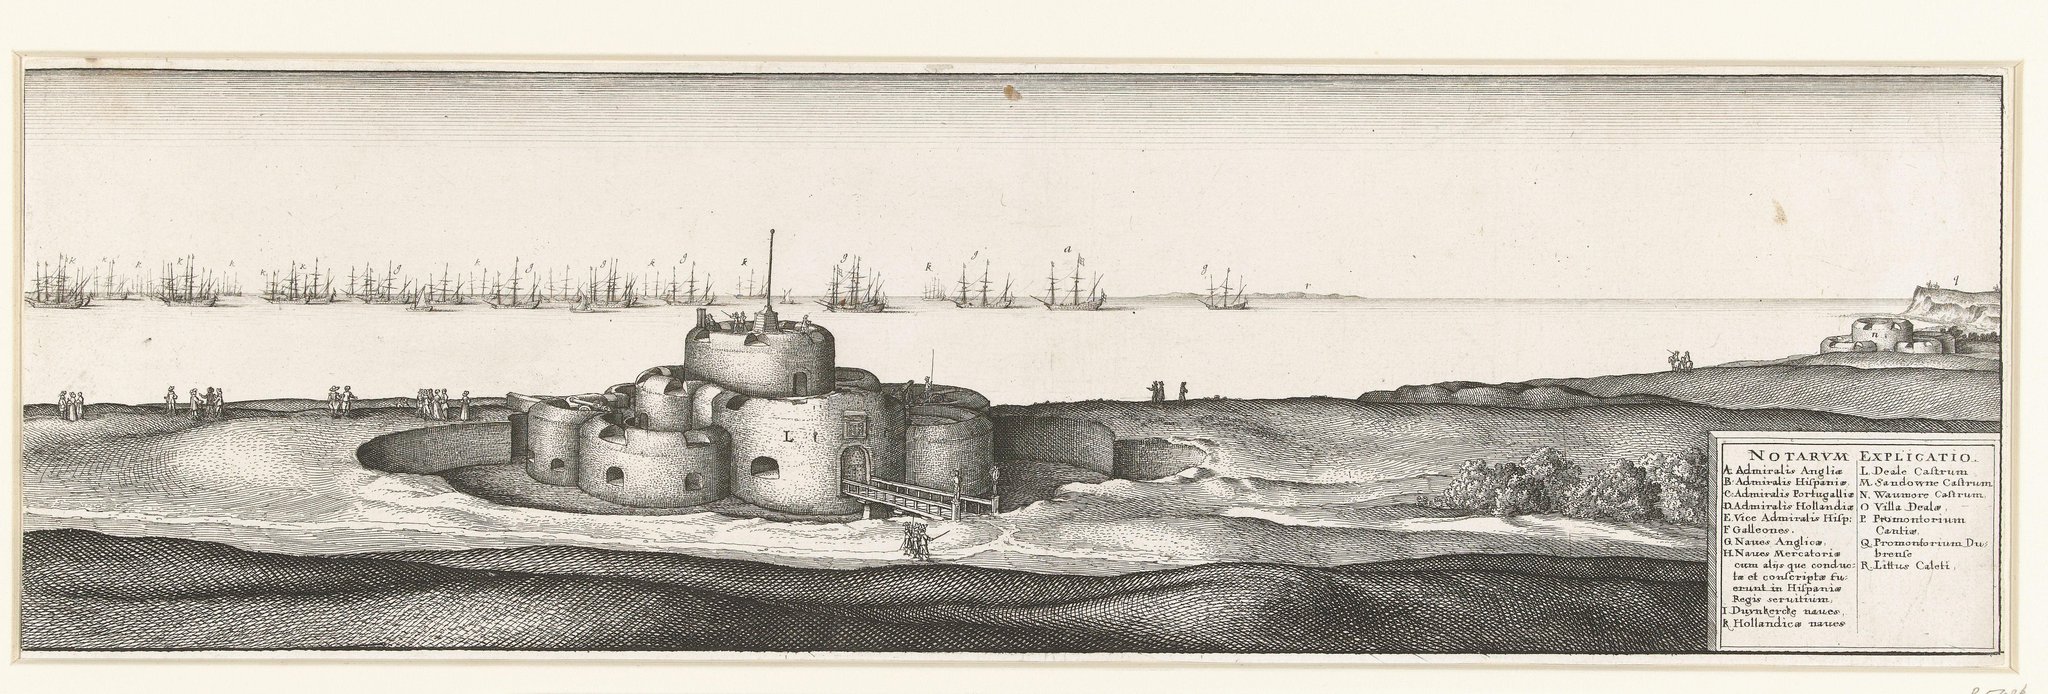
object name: print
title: De Spaanse, Engelse en Hollandse vloten voor Deal (rechterhelft), 1639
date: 1640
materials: paper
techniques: engraving, etching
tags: brielle, maarten harpertszoon tromp, battle (+ naval force), battle of the downs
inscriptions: date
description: De Spaanse, Engelse en Hollandse vloten voor Deal, 20 oktober 1639, voorafgaand aan de zeeslag bij Duins op 21 oktober 1639. Rechterhelft van een voorstelling op twee bladen. Voor de kust de Hollandse vloot onder bevel van Maarten Tromp en Engelse schepen. Centraal op de voorgrond het kasteel van Deal, rechts Wavmore Castle. Rechts een cartouche met de legenda A-R in het Latijn.